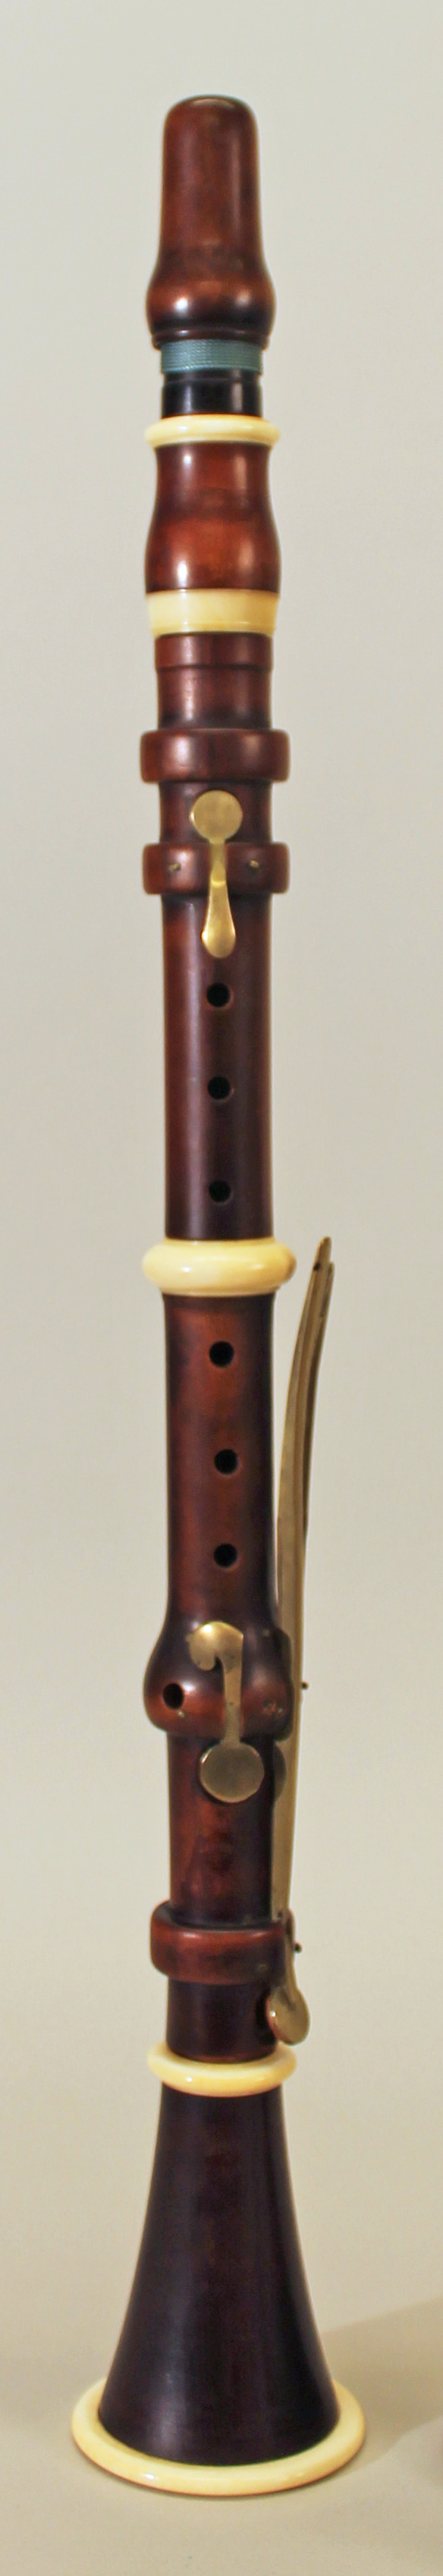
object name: clarinet in e flat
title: Clarinet in E-flat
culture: american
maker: henry h. prentiss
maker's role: maker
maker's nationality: american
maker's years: 1801-1860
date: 1830-1860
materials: wood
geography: united states